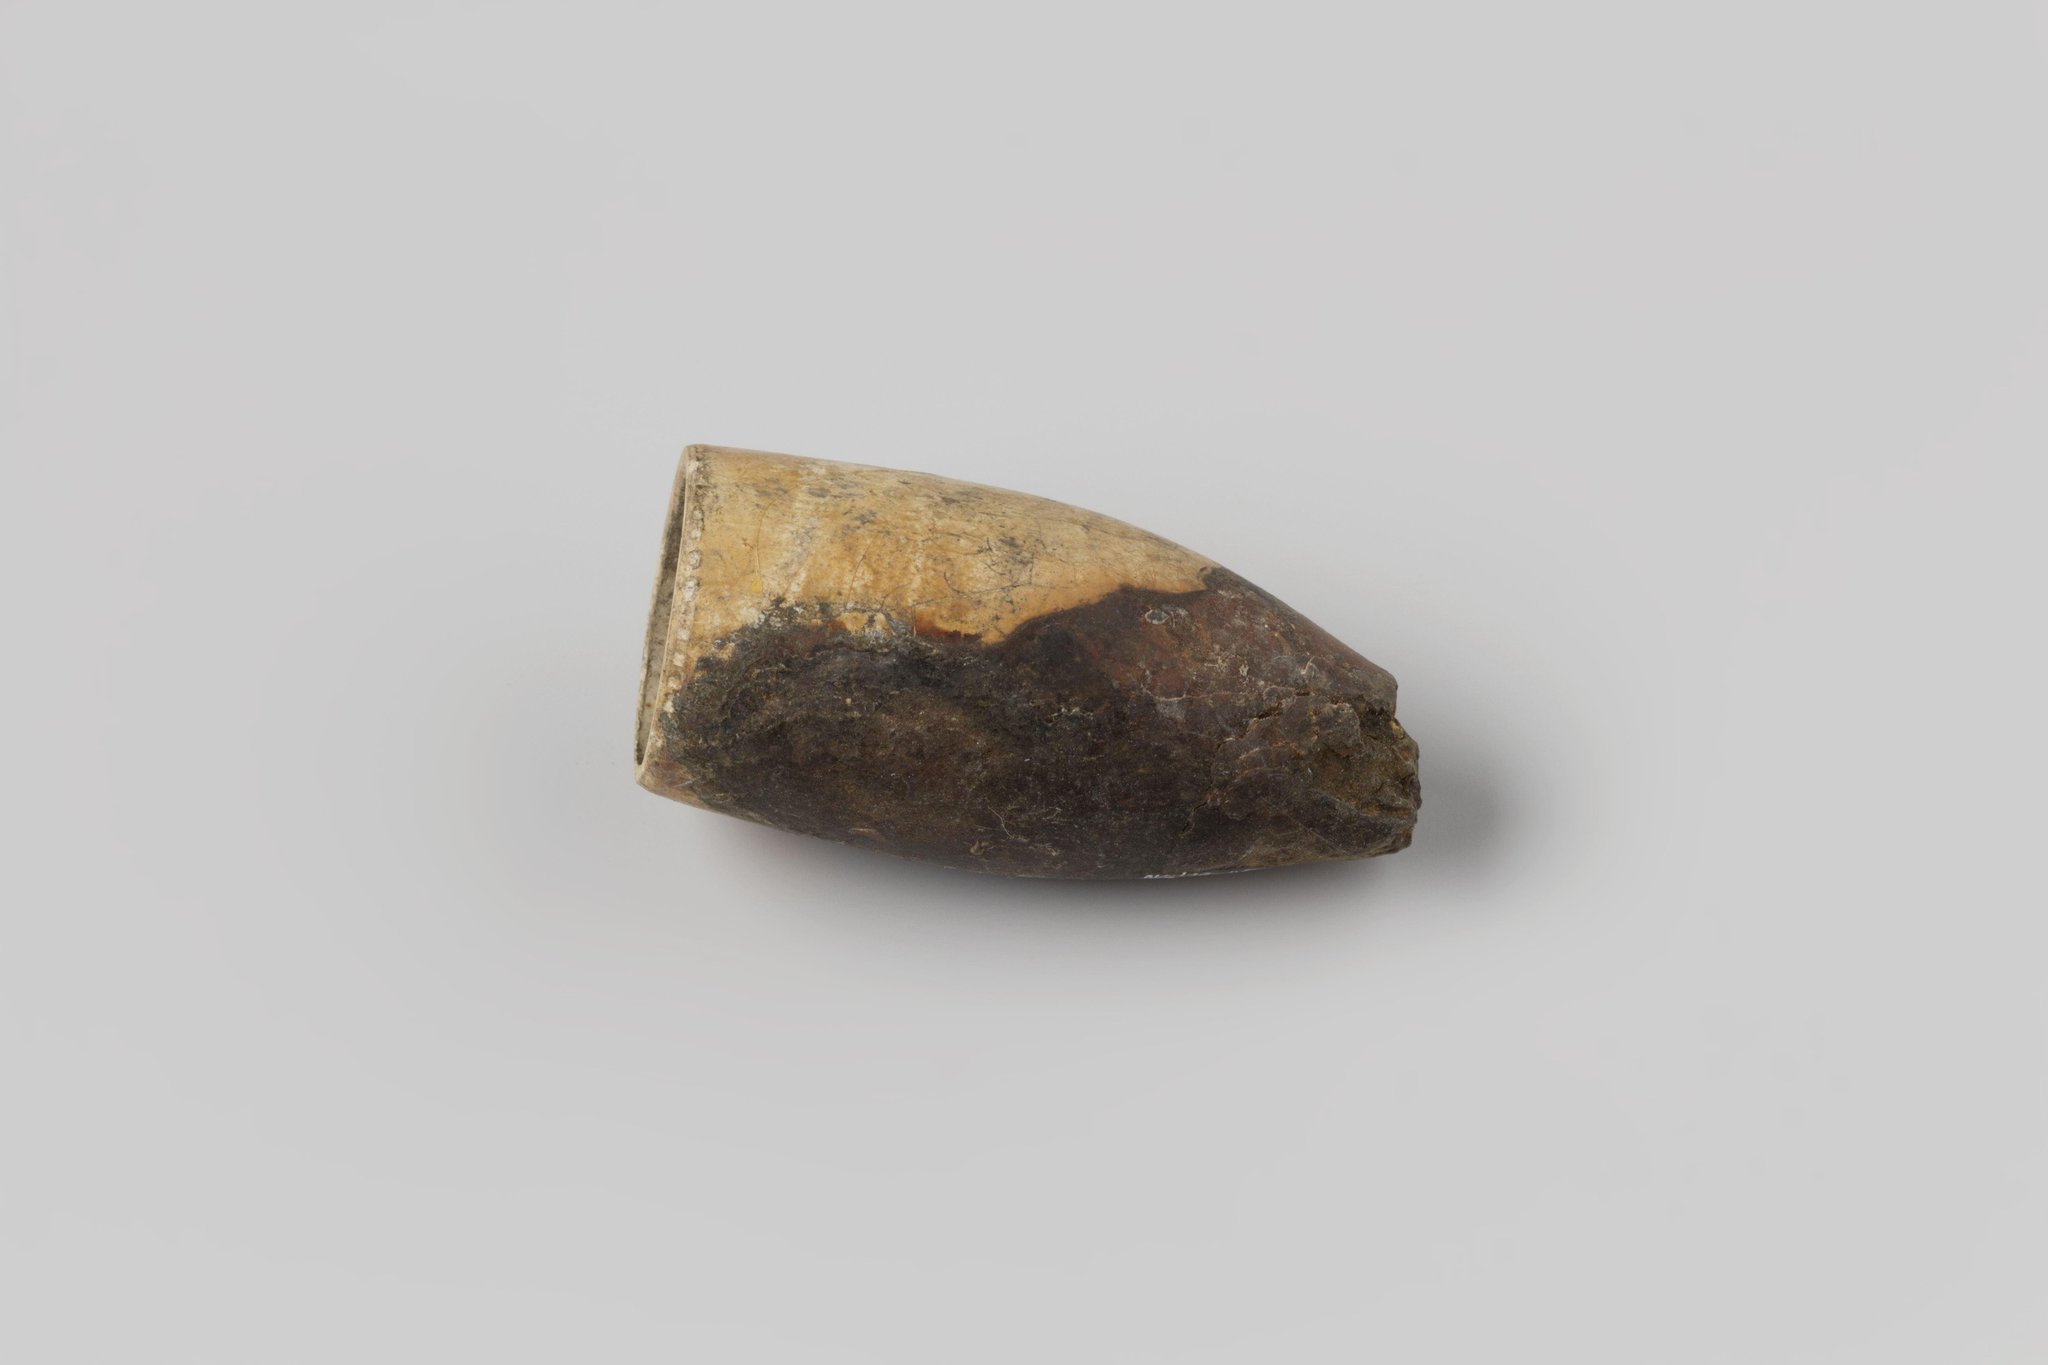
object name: pipe bowl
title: Fragment pijpenkop uit het wrak van de Oost-Indiëvaarder Hollandia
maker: Anonymous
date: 1700-1743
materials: clay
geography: netherlands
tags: verenigde oostindische compagnie, hollandia (schip), annet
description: Pipe, bowl, heelmark illegible; fragment.